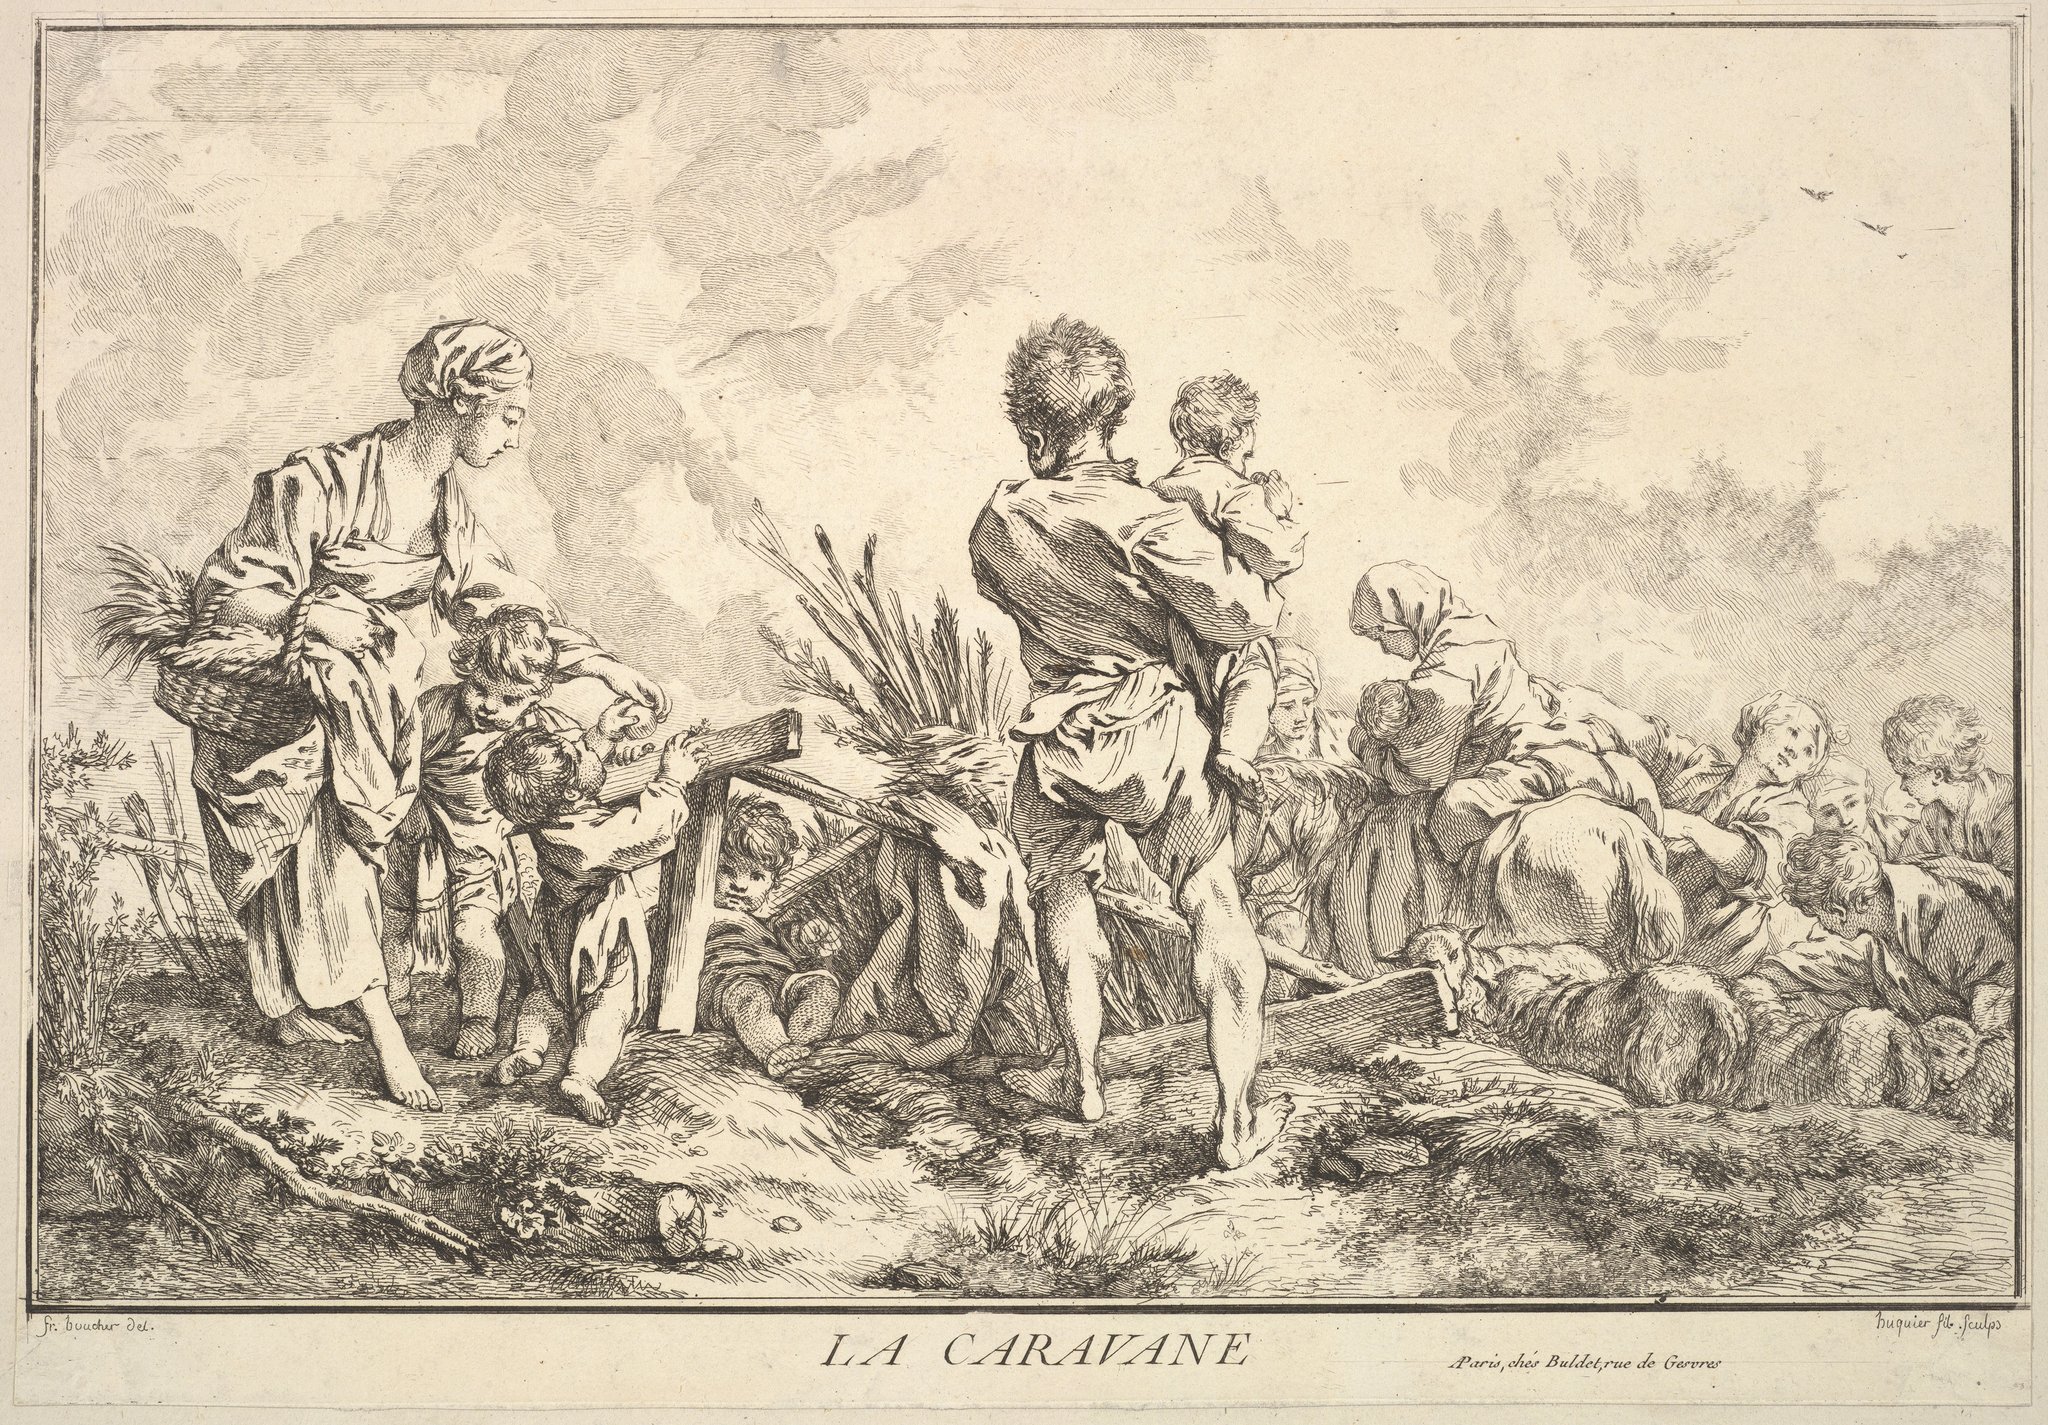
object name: print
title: The Caravan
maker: jacques gabriel huquier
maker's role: artist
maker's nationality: french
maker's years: 1730-1805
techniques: etching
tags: children,men,women